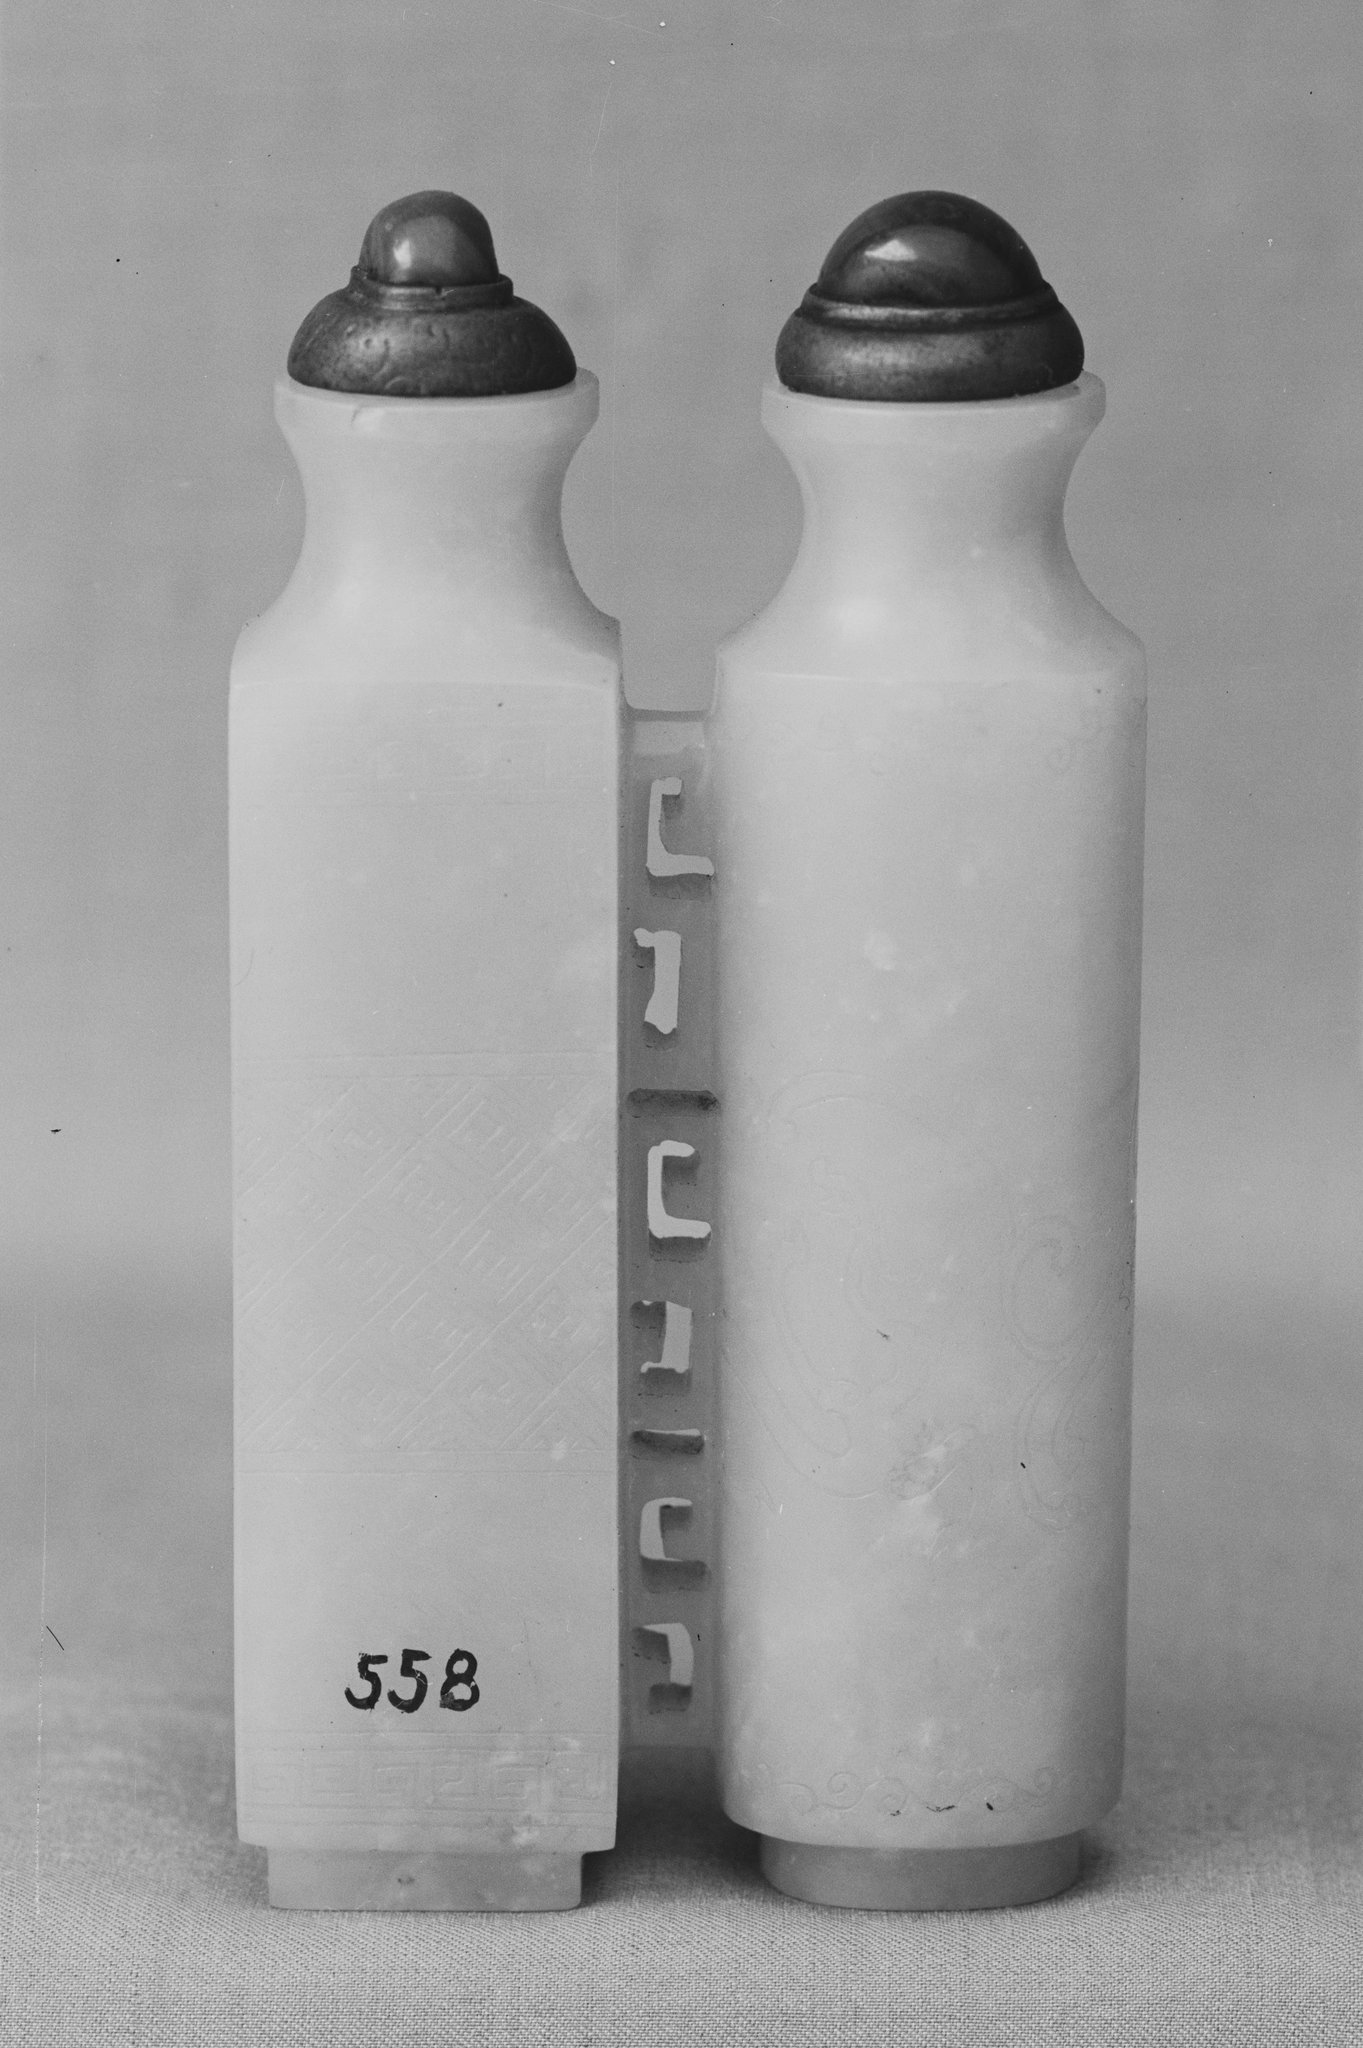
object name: snuff bottle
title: Double Snuff Bottle with Stoppers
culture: chinese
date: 1736-1795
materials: jade